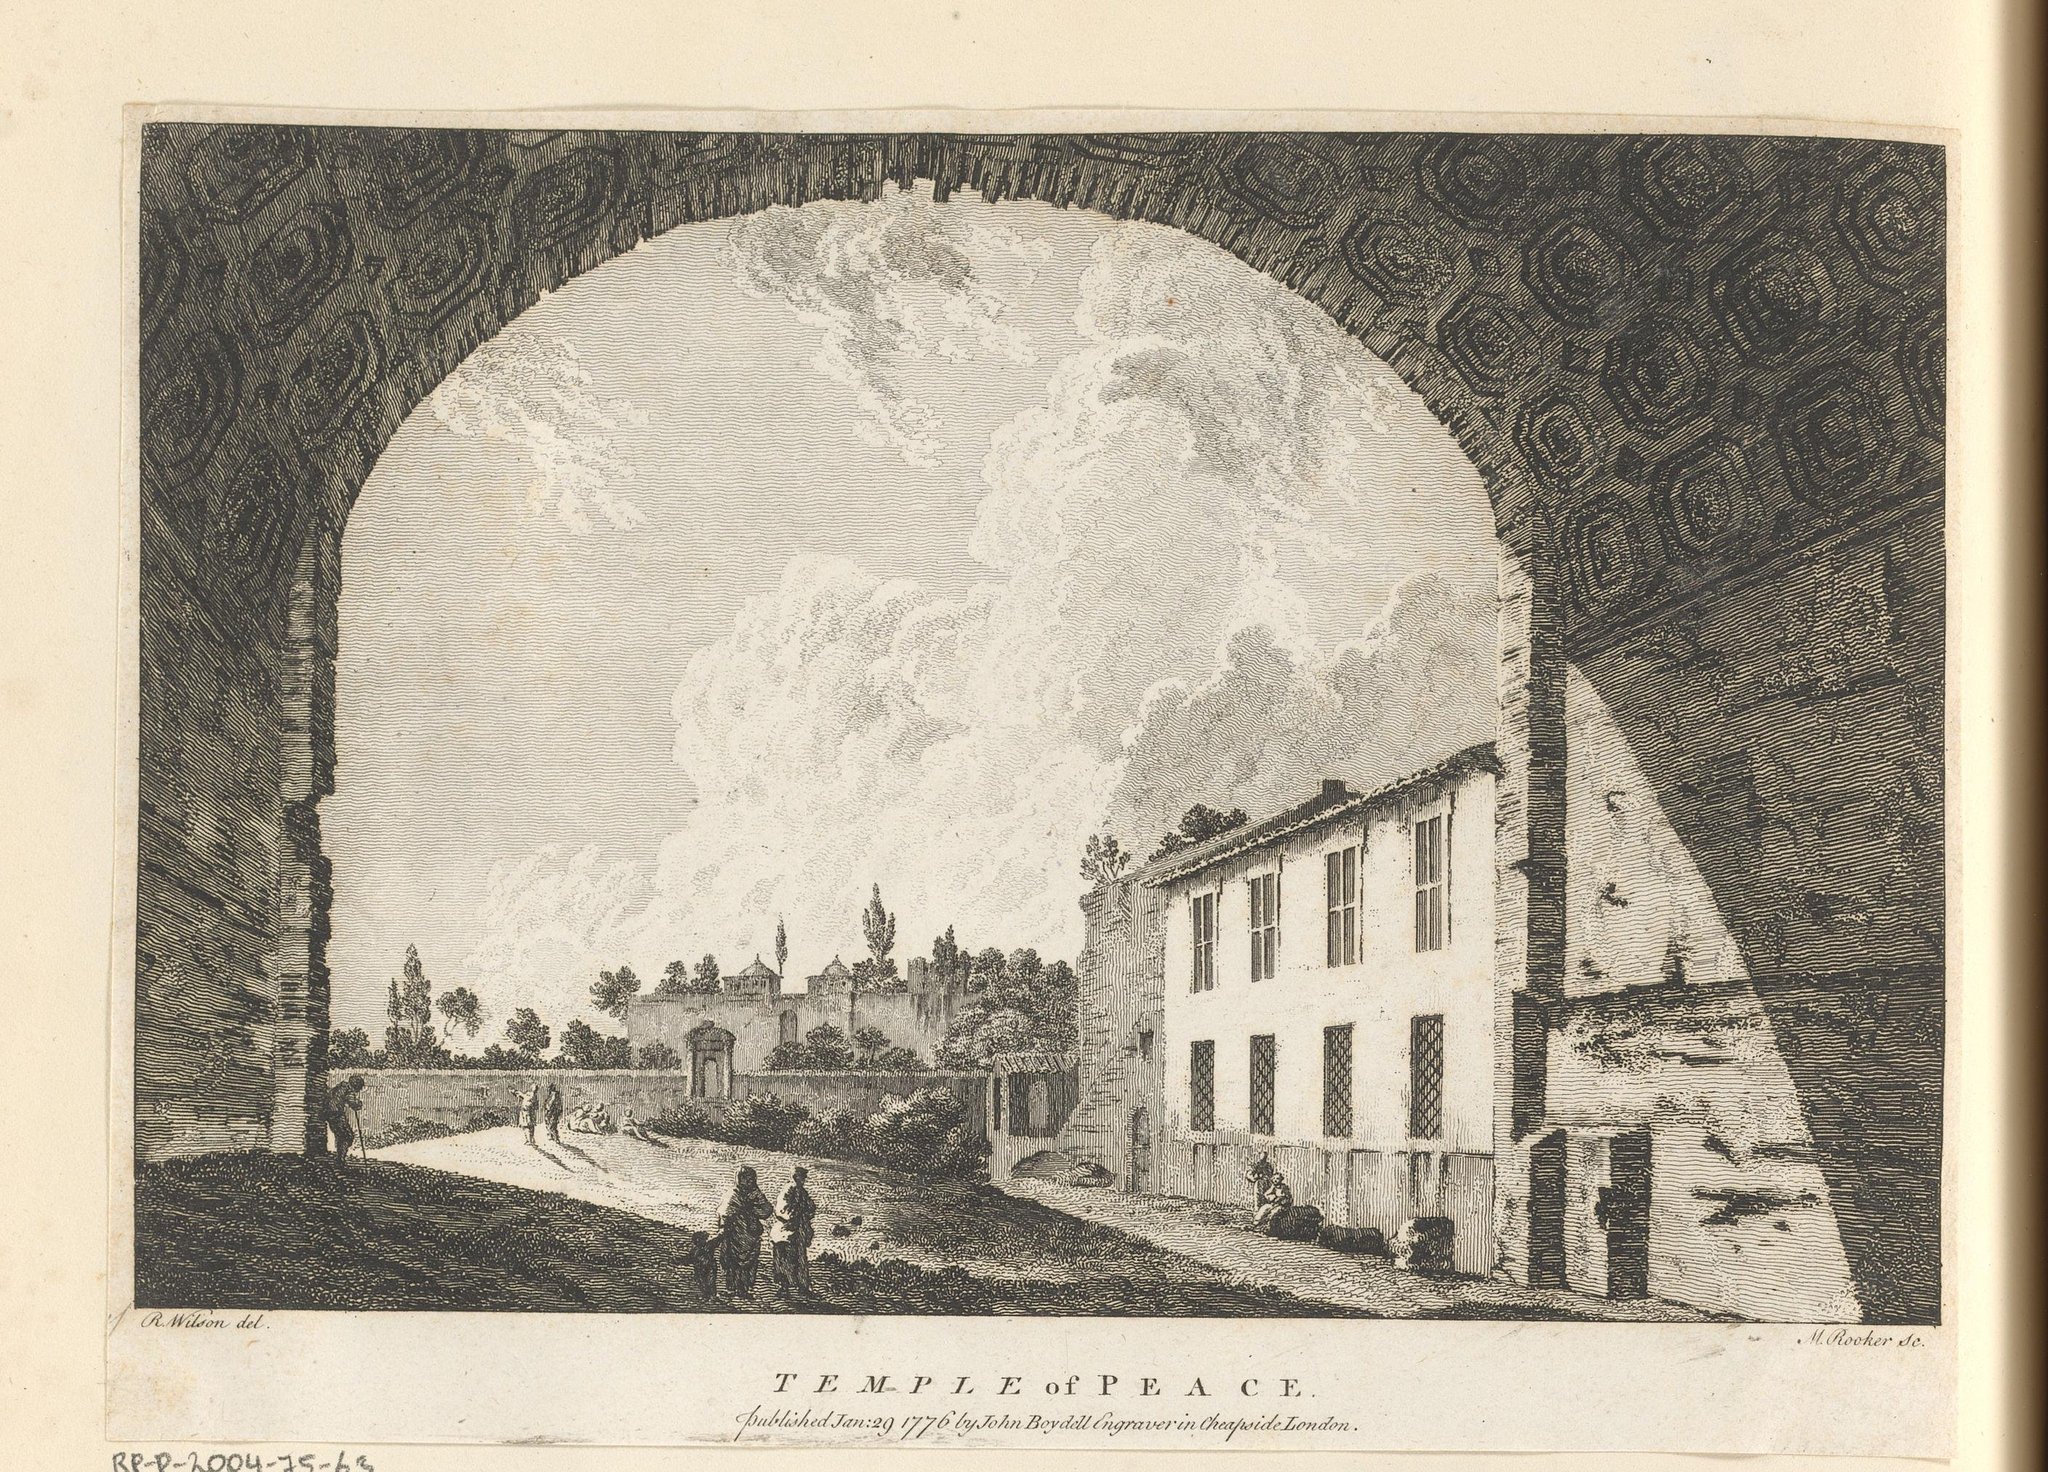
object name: album leaf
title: Binnenplaats gezien vanuit een passage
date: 1776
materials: paper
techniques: engraving, etching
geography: london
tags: courtyard, passage, italy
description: De samensteller heeft deze prent in het album geplakt als illustratie bij: Pilkington, Matthew en Johann Heinrich Füssli. A dictionary of painters, from the revival of the art to the present period. 4 dln. Londen: John Crowder, 1805, dl. 4, p. 648.